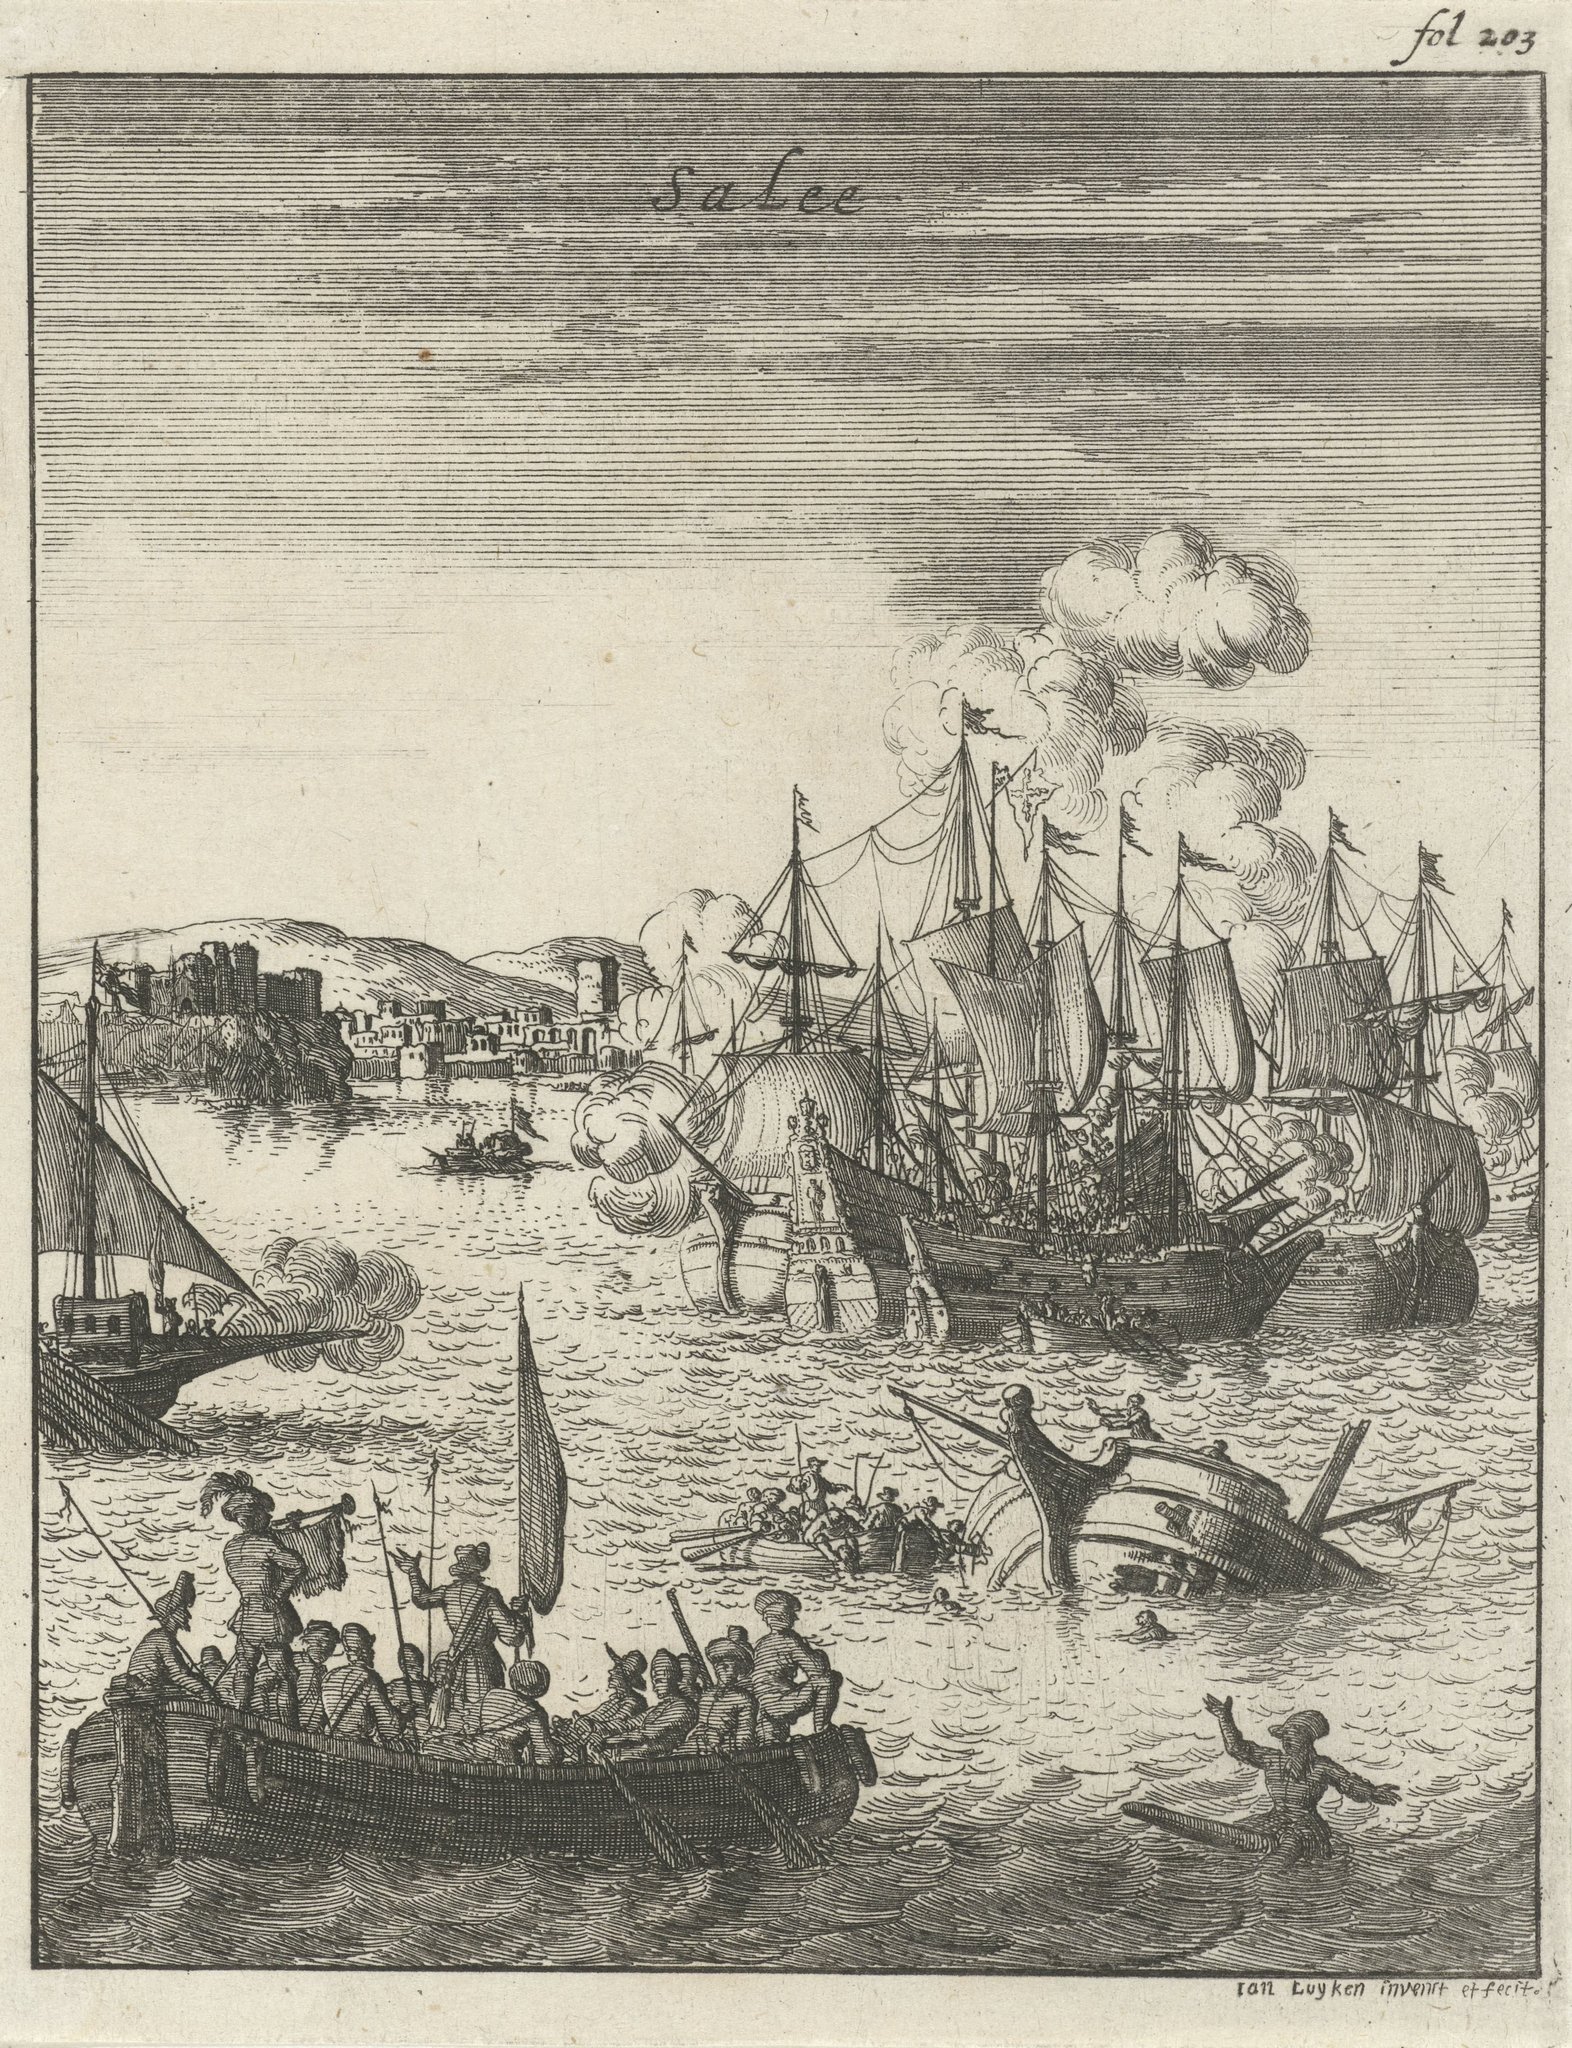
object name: book illustration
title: Salee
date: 1684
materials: paper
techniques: etching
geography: amsterdam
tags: battle (+ sailing-ships)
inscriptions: collector's mark: Lugt 2228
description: Prent uit: Dan, Pierre. Historie van Barbaryen, en des zelfs zee-roovers (...). 2 dln. Amsterdam: Jan Claesz ten Hoorn, 1684, dl. 1, p. 203.